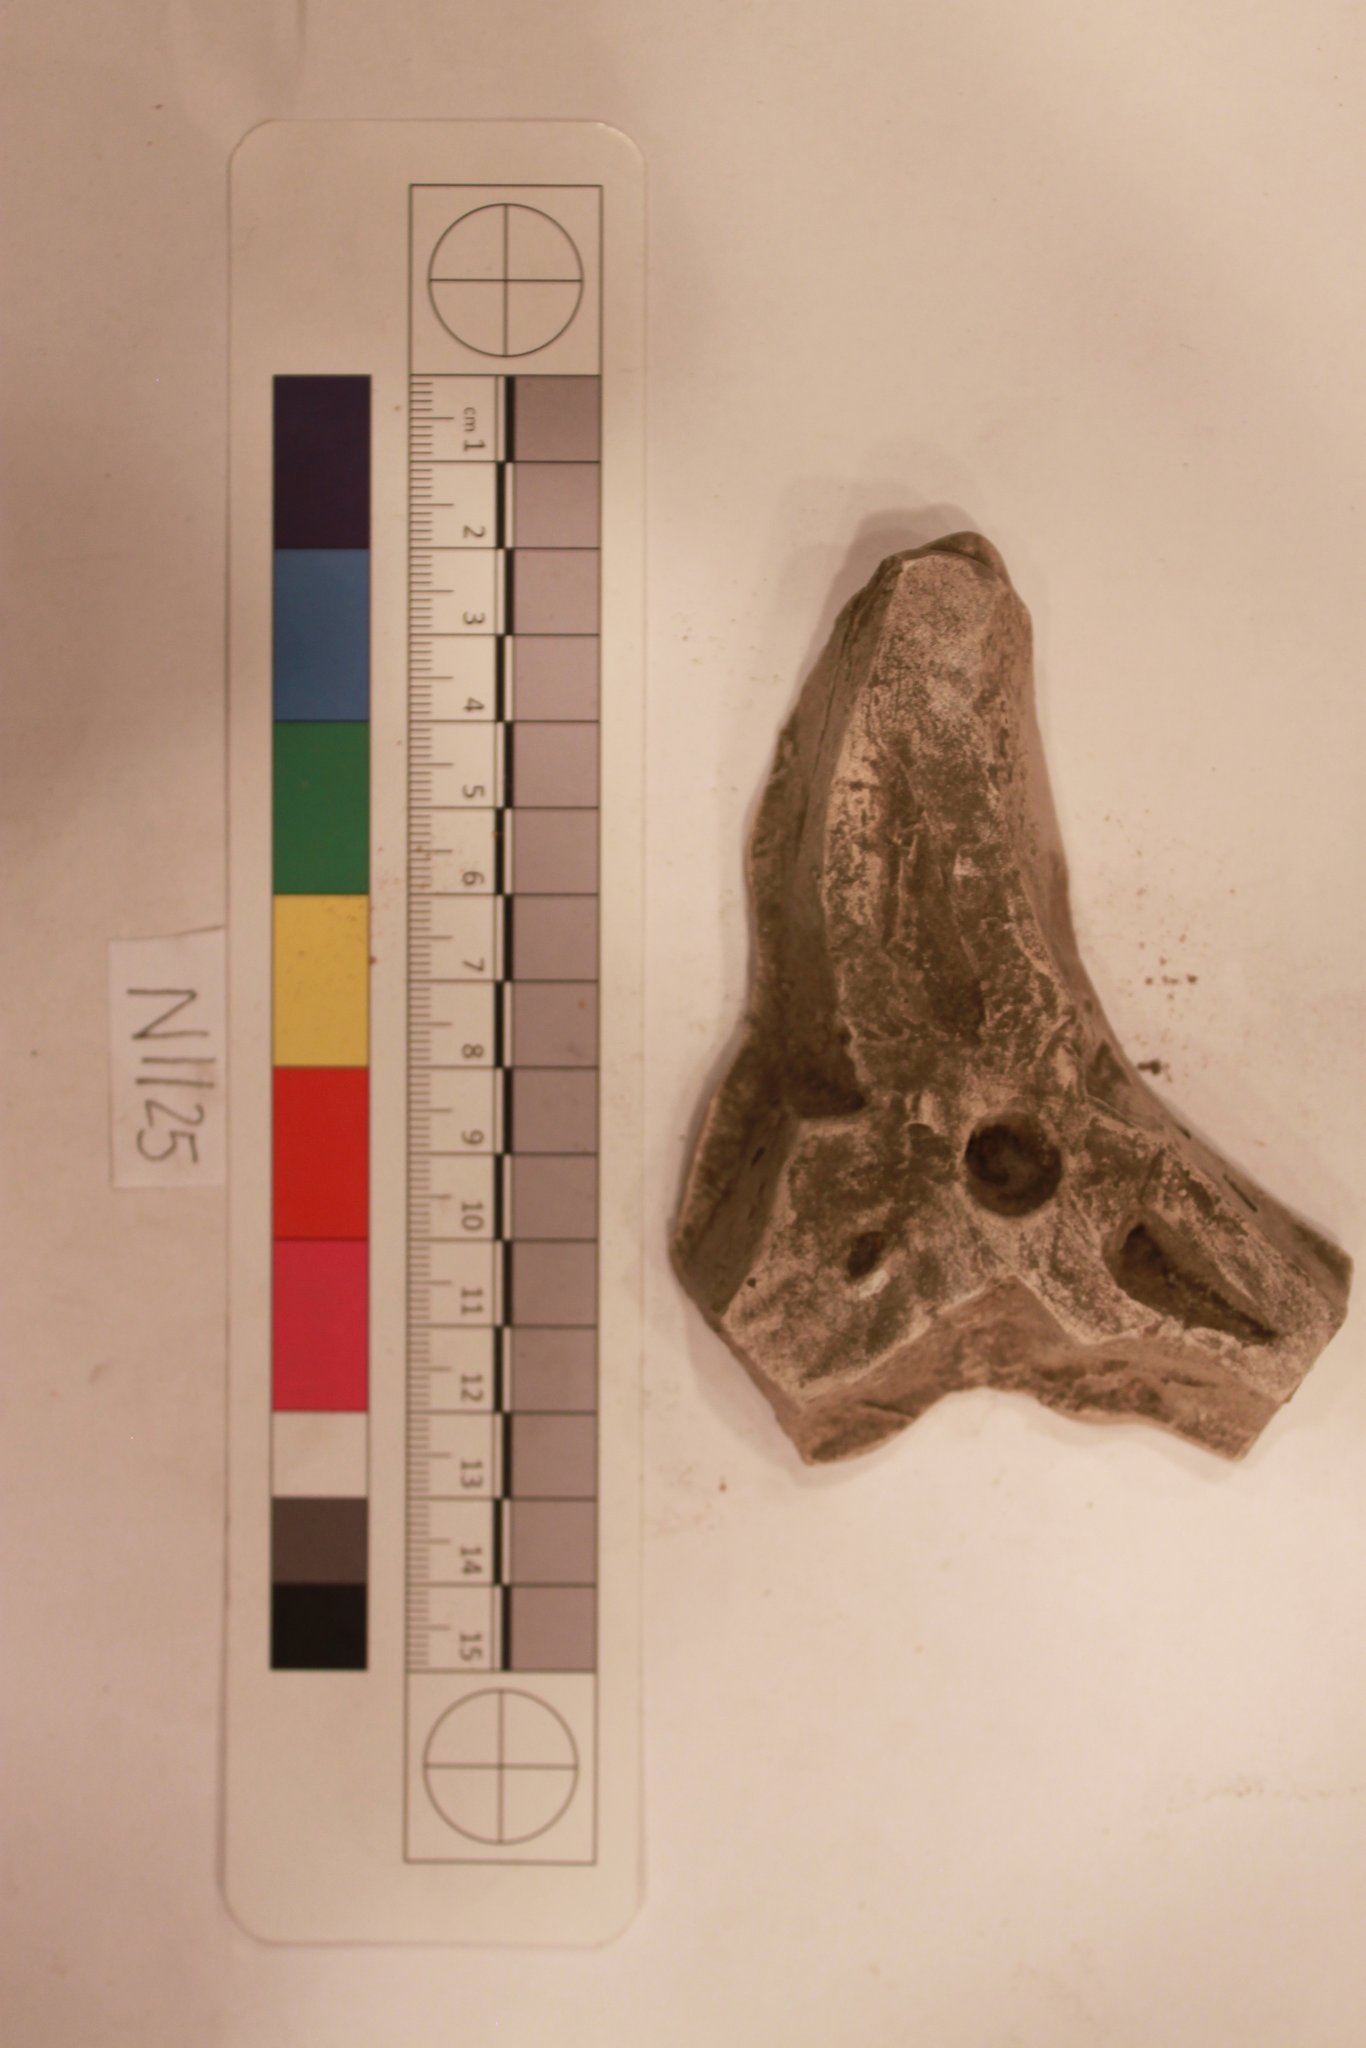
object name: fragment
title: Stucco Fragment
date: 701-1200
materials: gypsum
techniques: carving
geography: iran